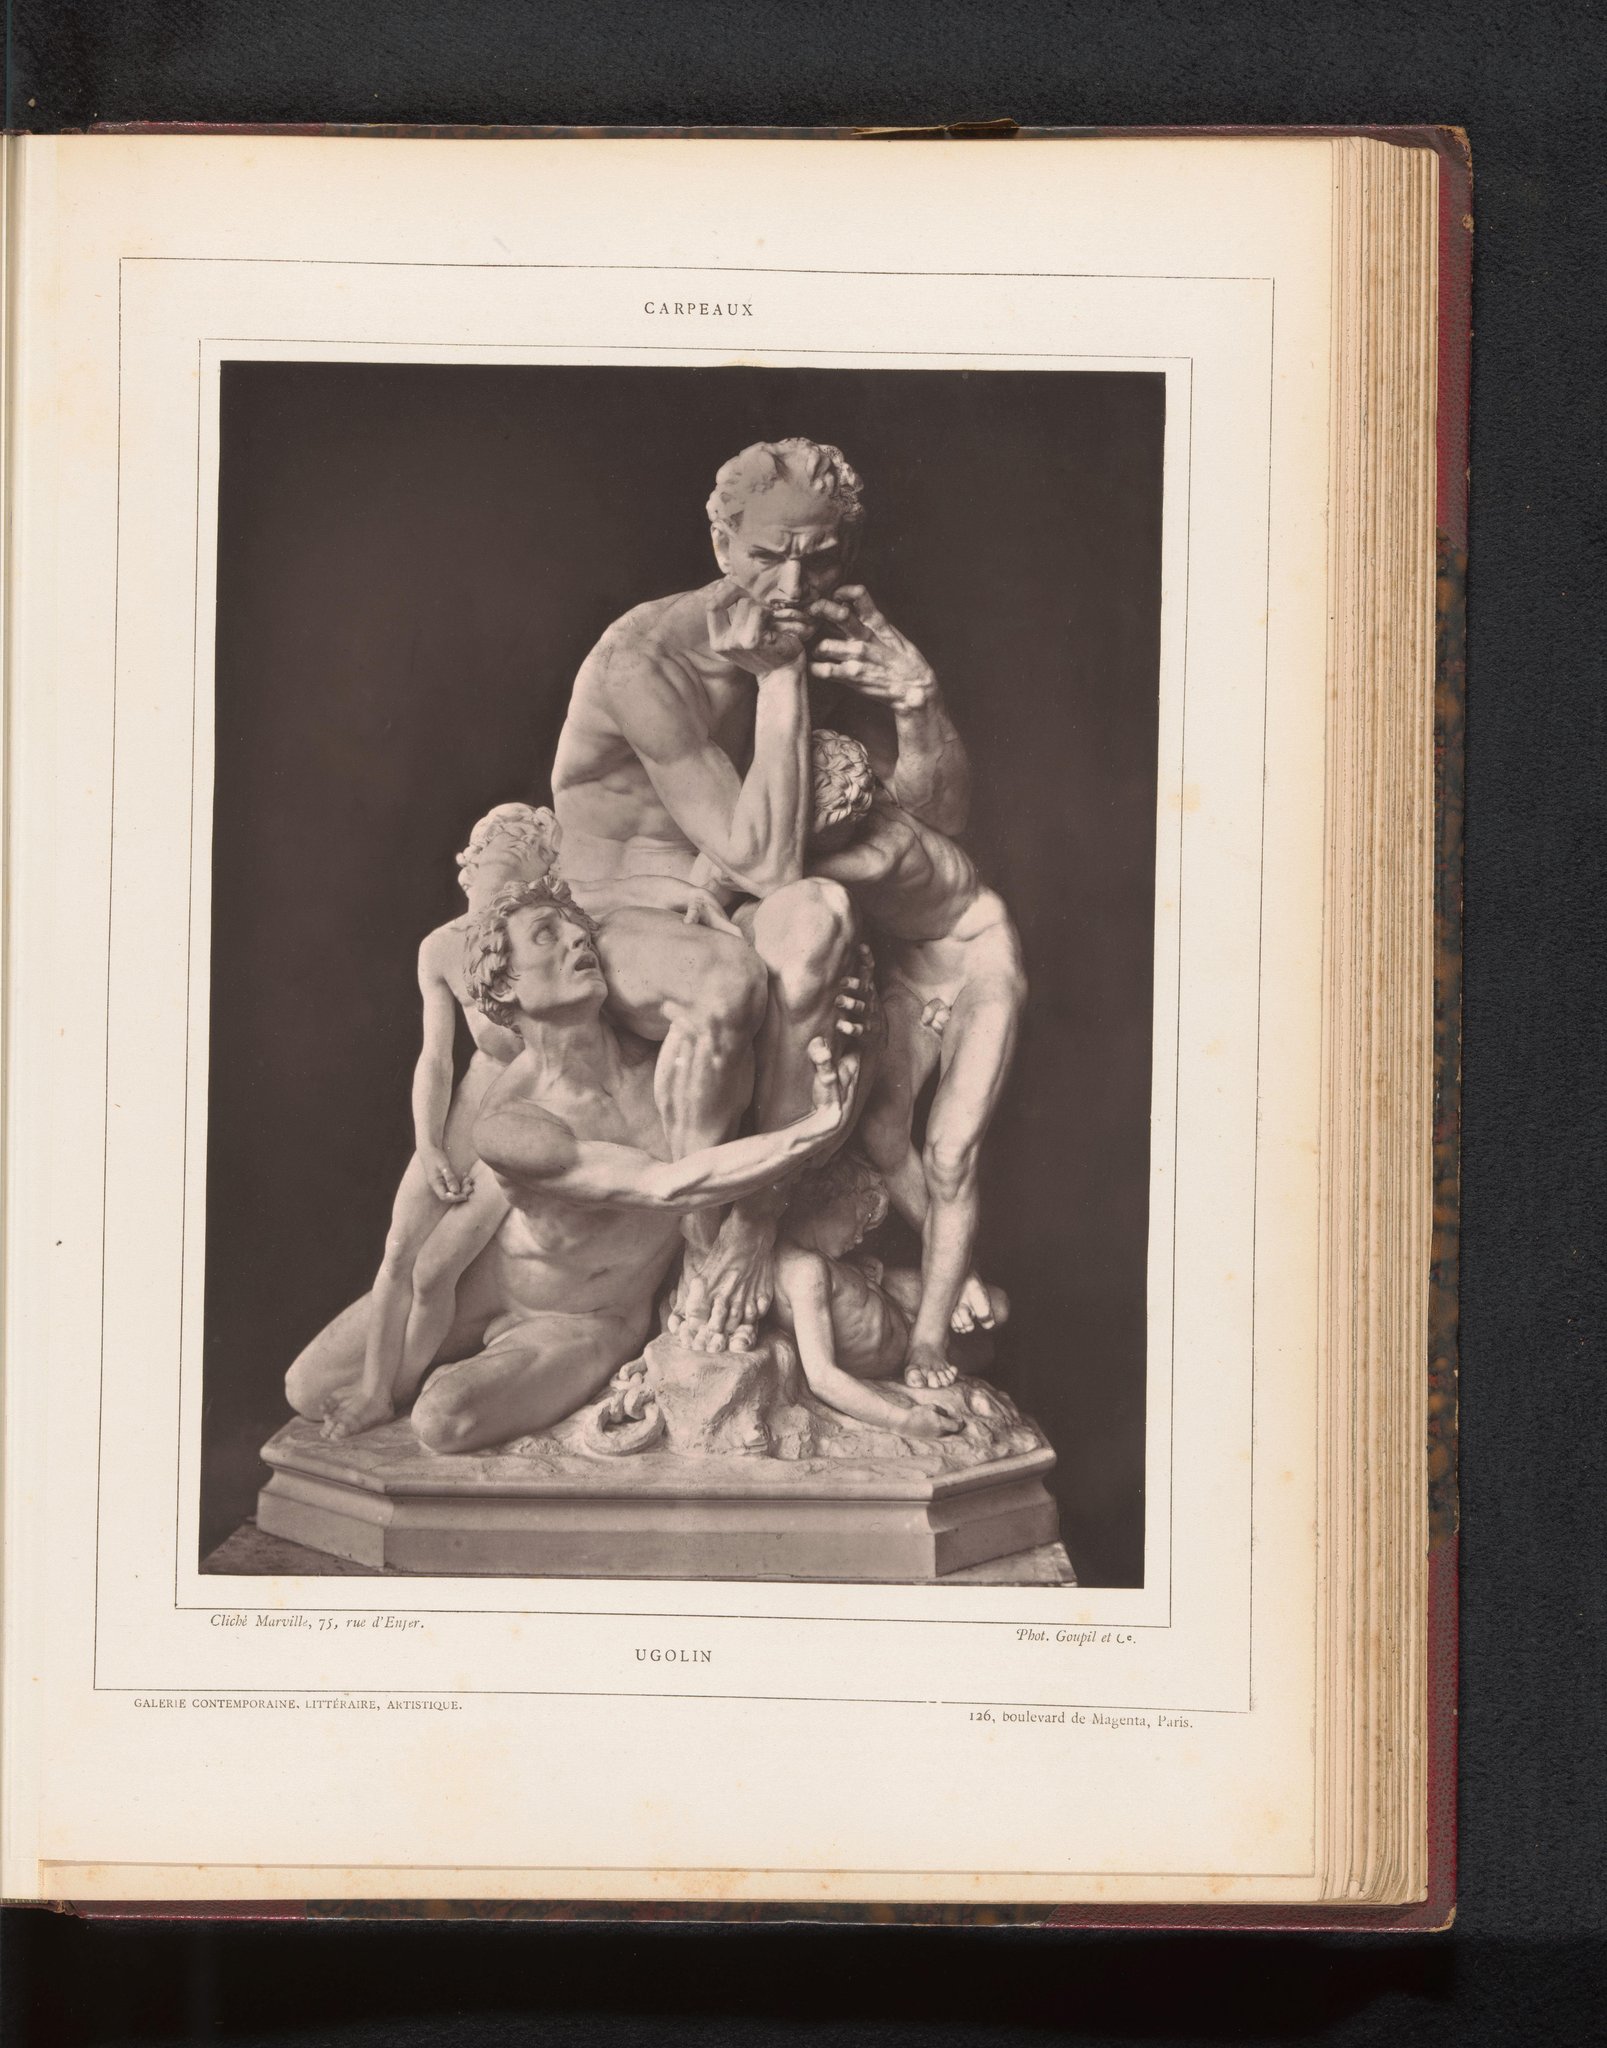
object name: photomechanical print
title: Ugolin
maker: charles marville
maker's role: print maker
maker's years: 1816-1879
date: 1871-1876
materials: paper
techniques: woodburytype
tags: historical persons, sculpture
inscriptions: inscription: ‘Carpeaux/ Galerie Contemporaine, Littéraire et Artistique/ 126, boulevard de Magenta.’